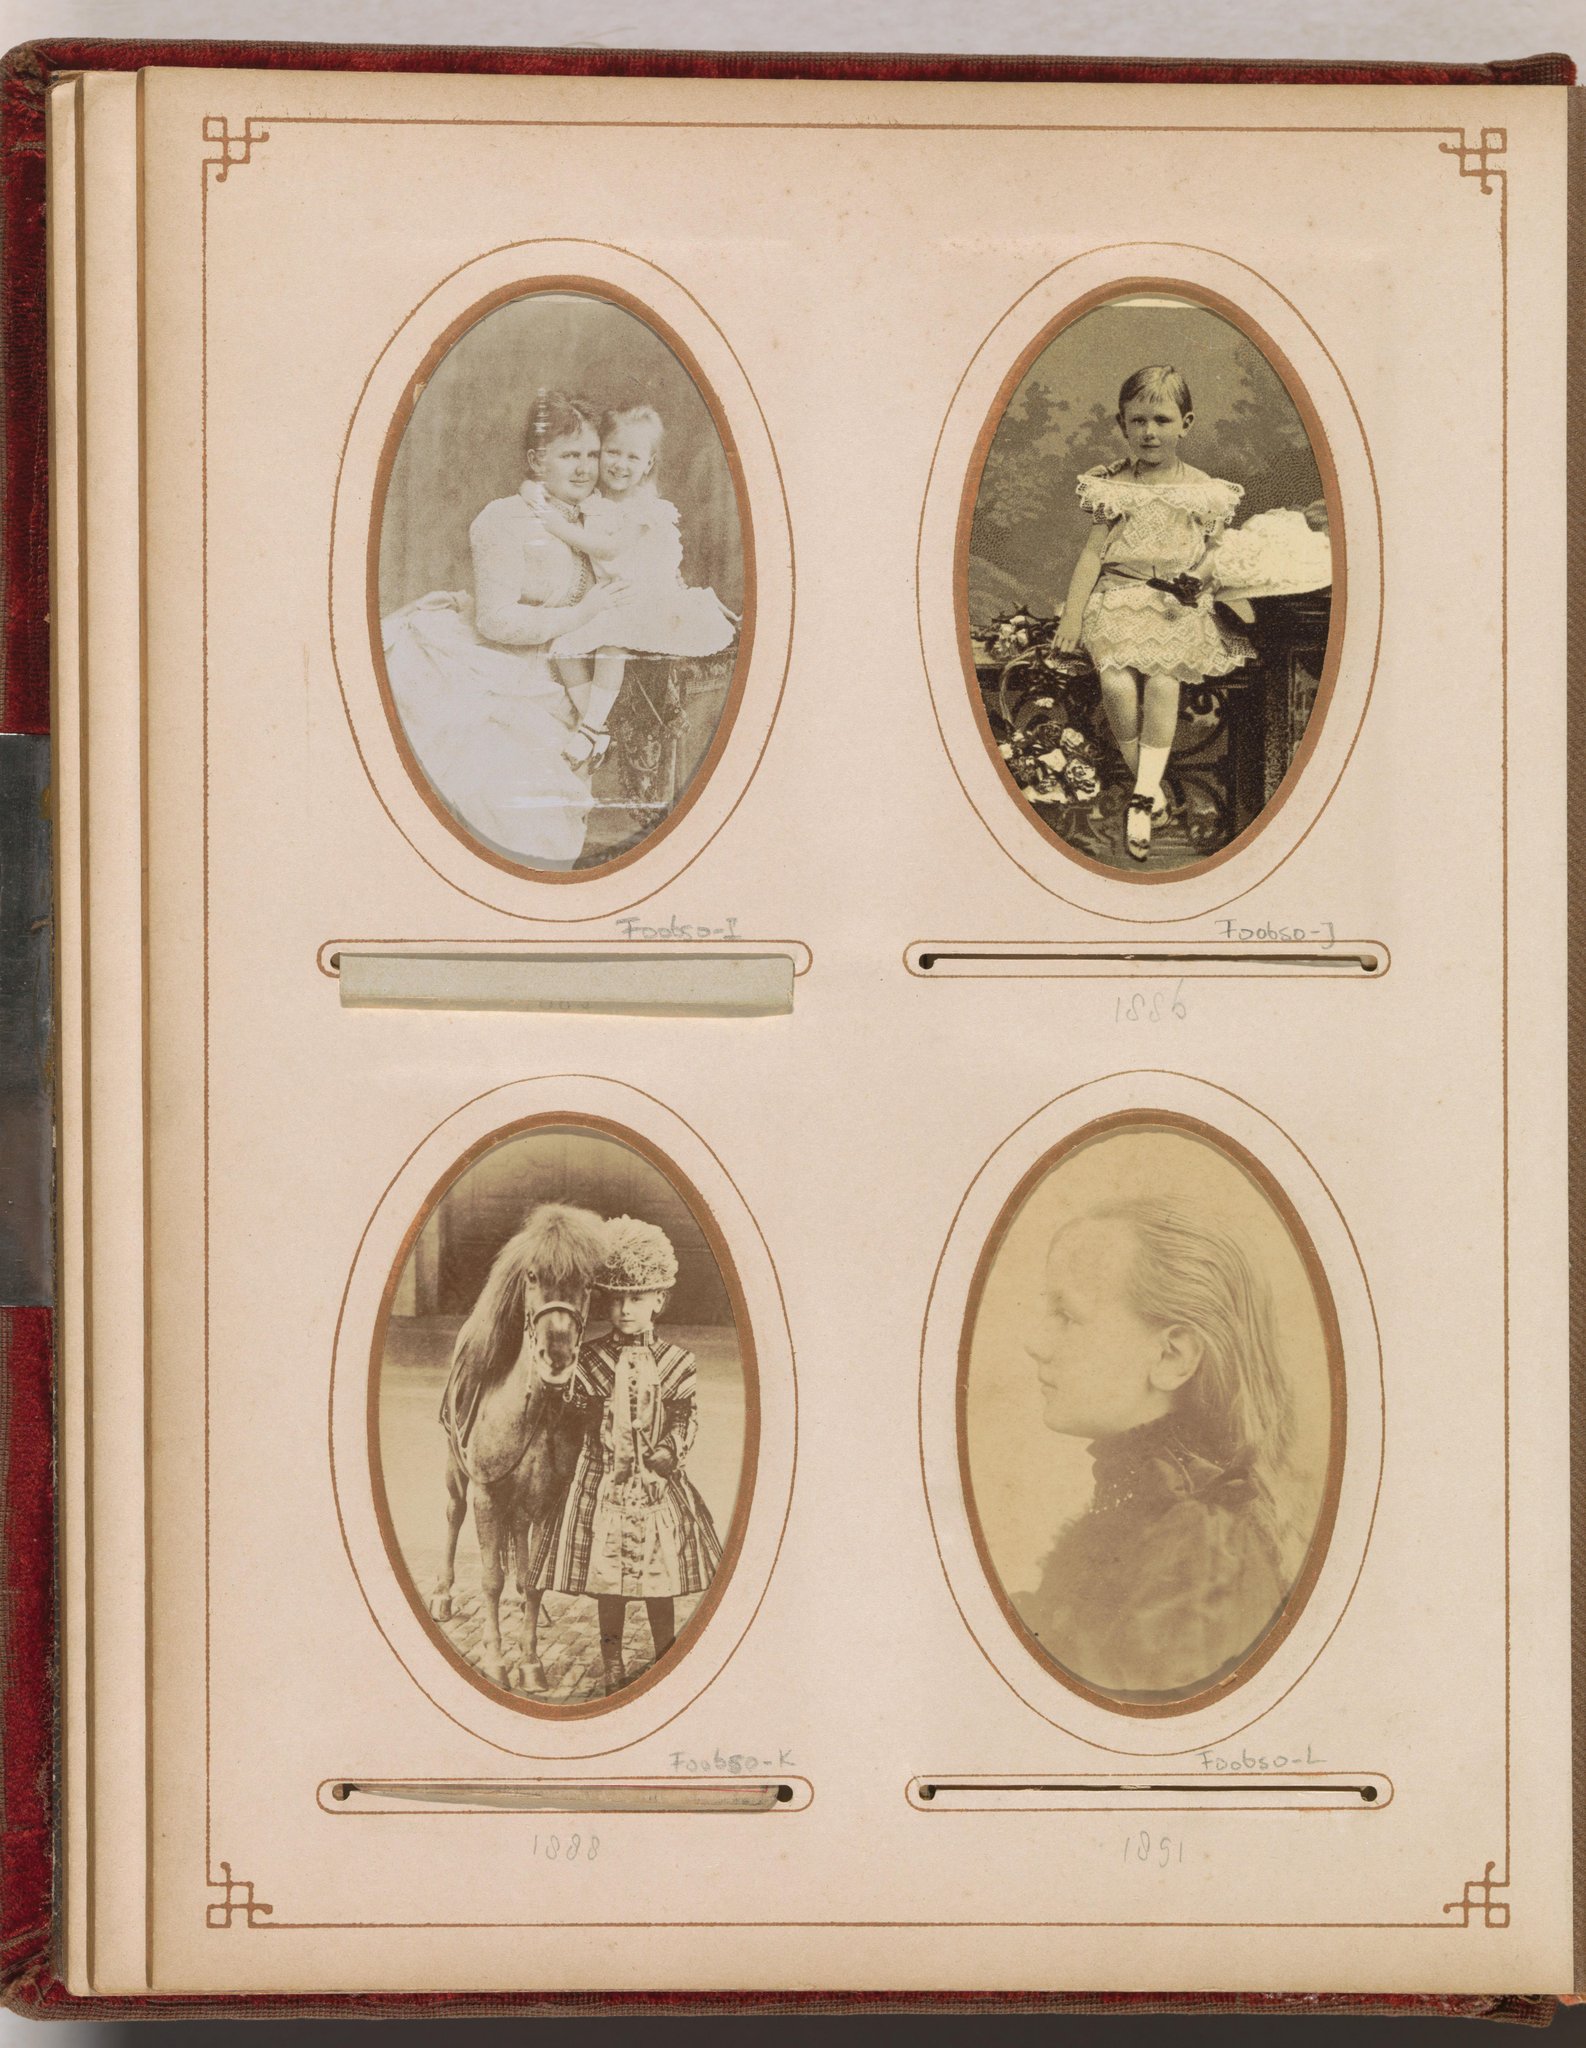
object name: album leaf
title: Portret van koningin Emma met prinses Wilhelmina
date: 1806-1885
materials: cardboard, paper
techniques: autotype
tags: print maker, wilhelmina of the netherlands, the hague, emma (queen consort of the netherlands), historical persons - bb - woman, mother and daughter(s) (family group)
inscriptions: date: ‘1885’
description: Deze fotomechanische afdruk maakt deel uit van een album.